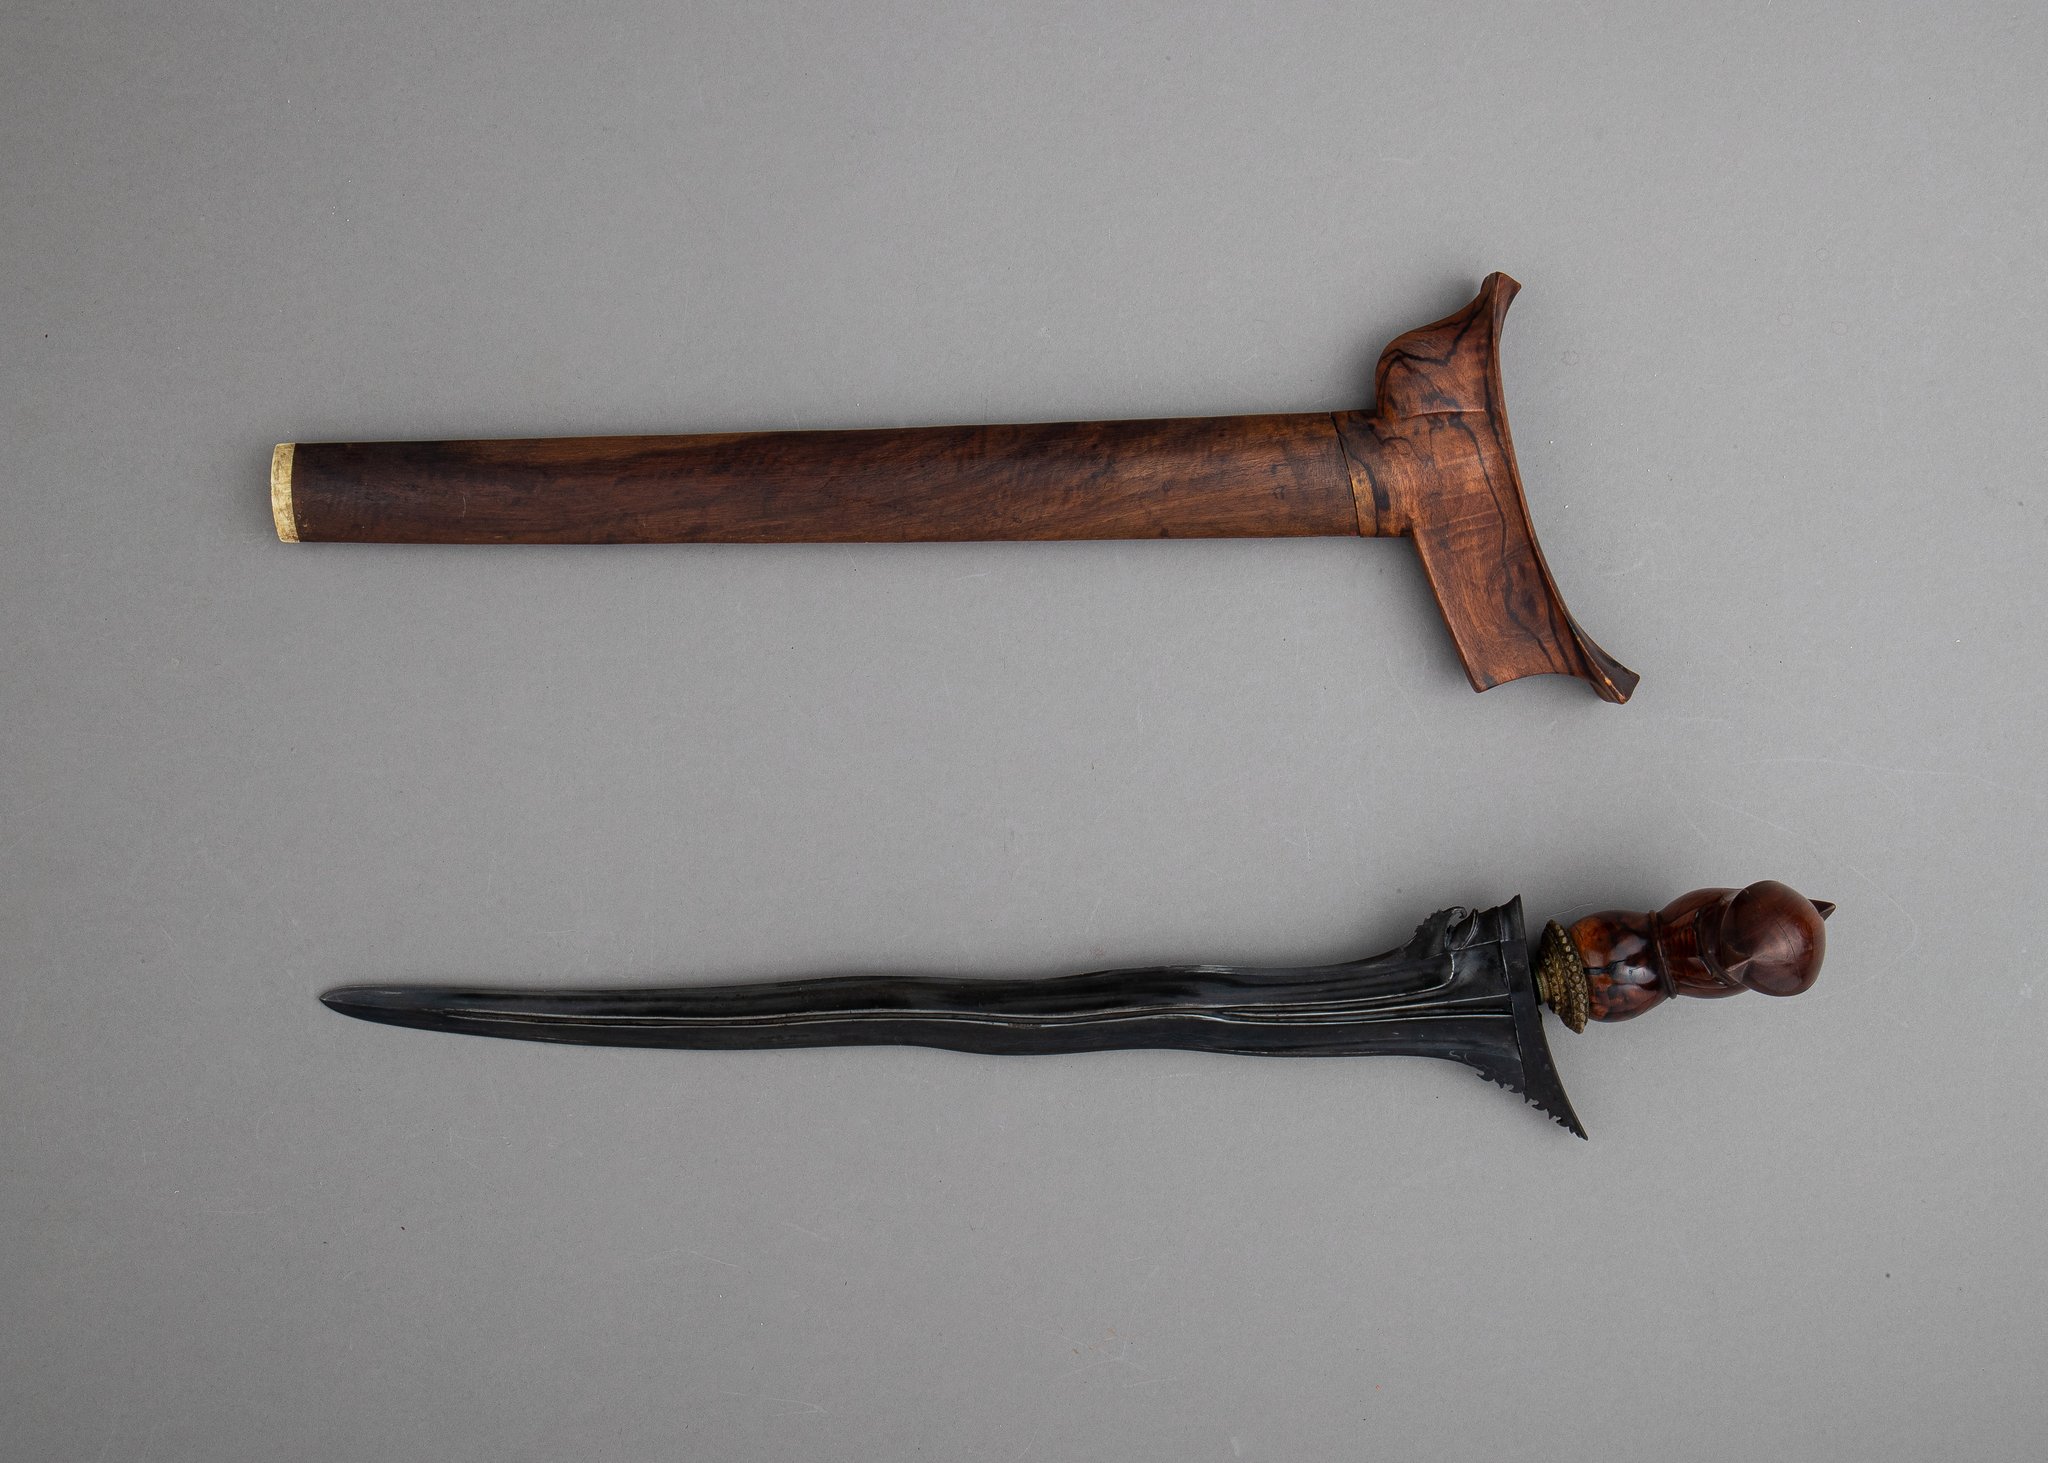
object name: kris with sheath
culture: sumatran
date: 1501-1900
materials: bone, brass, steel, wood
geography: indonesia